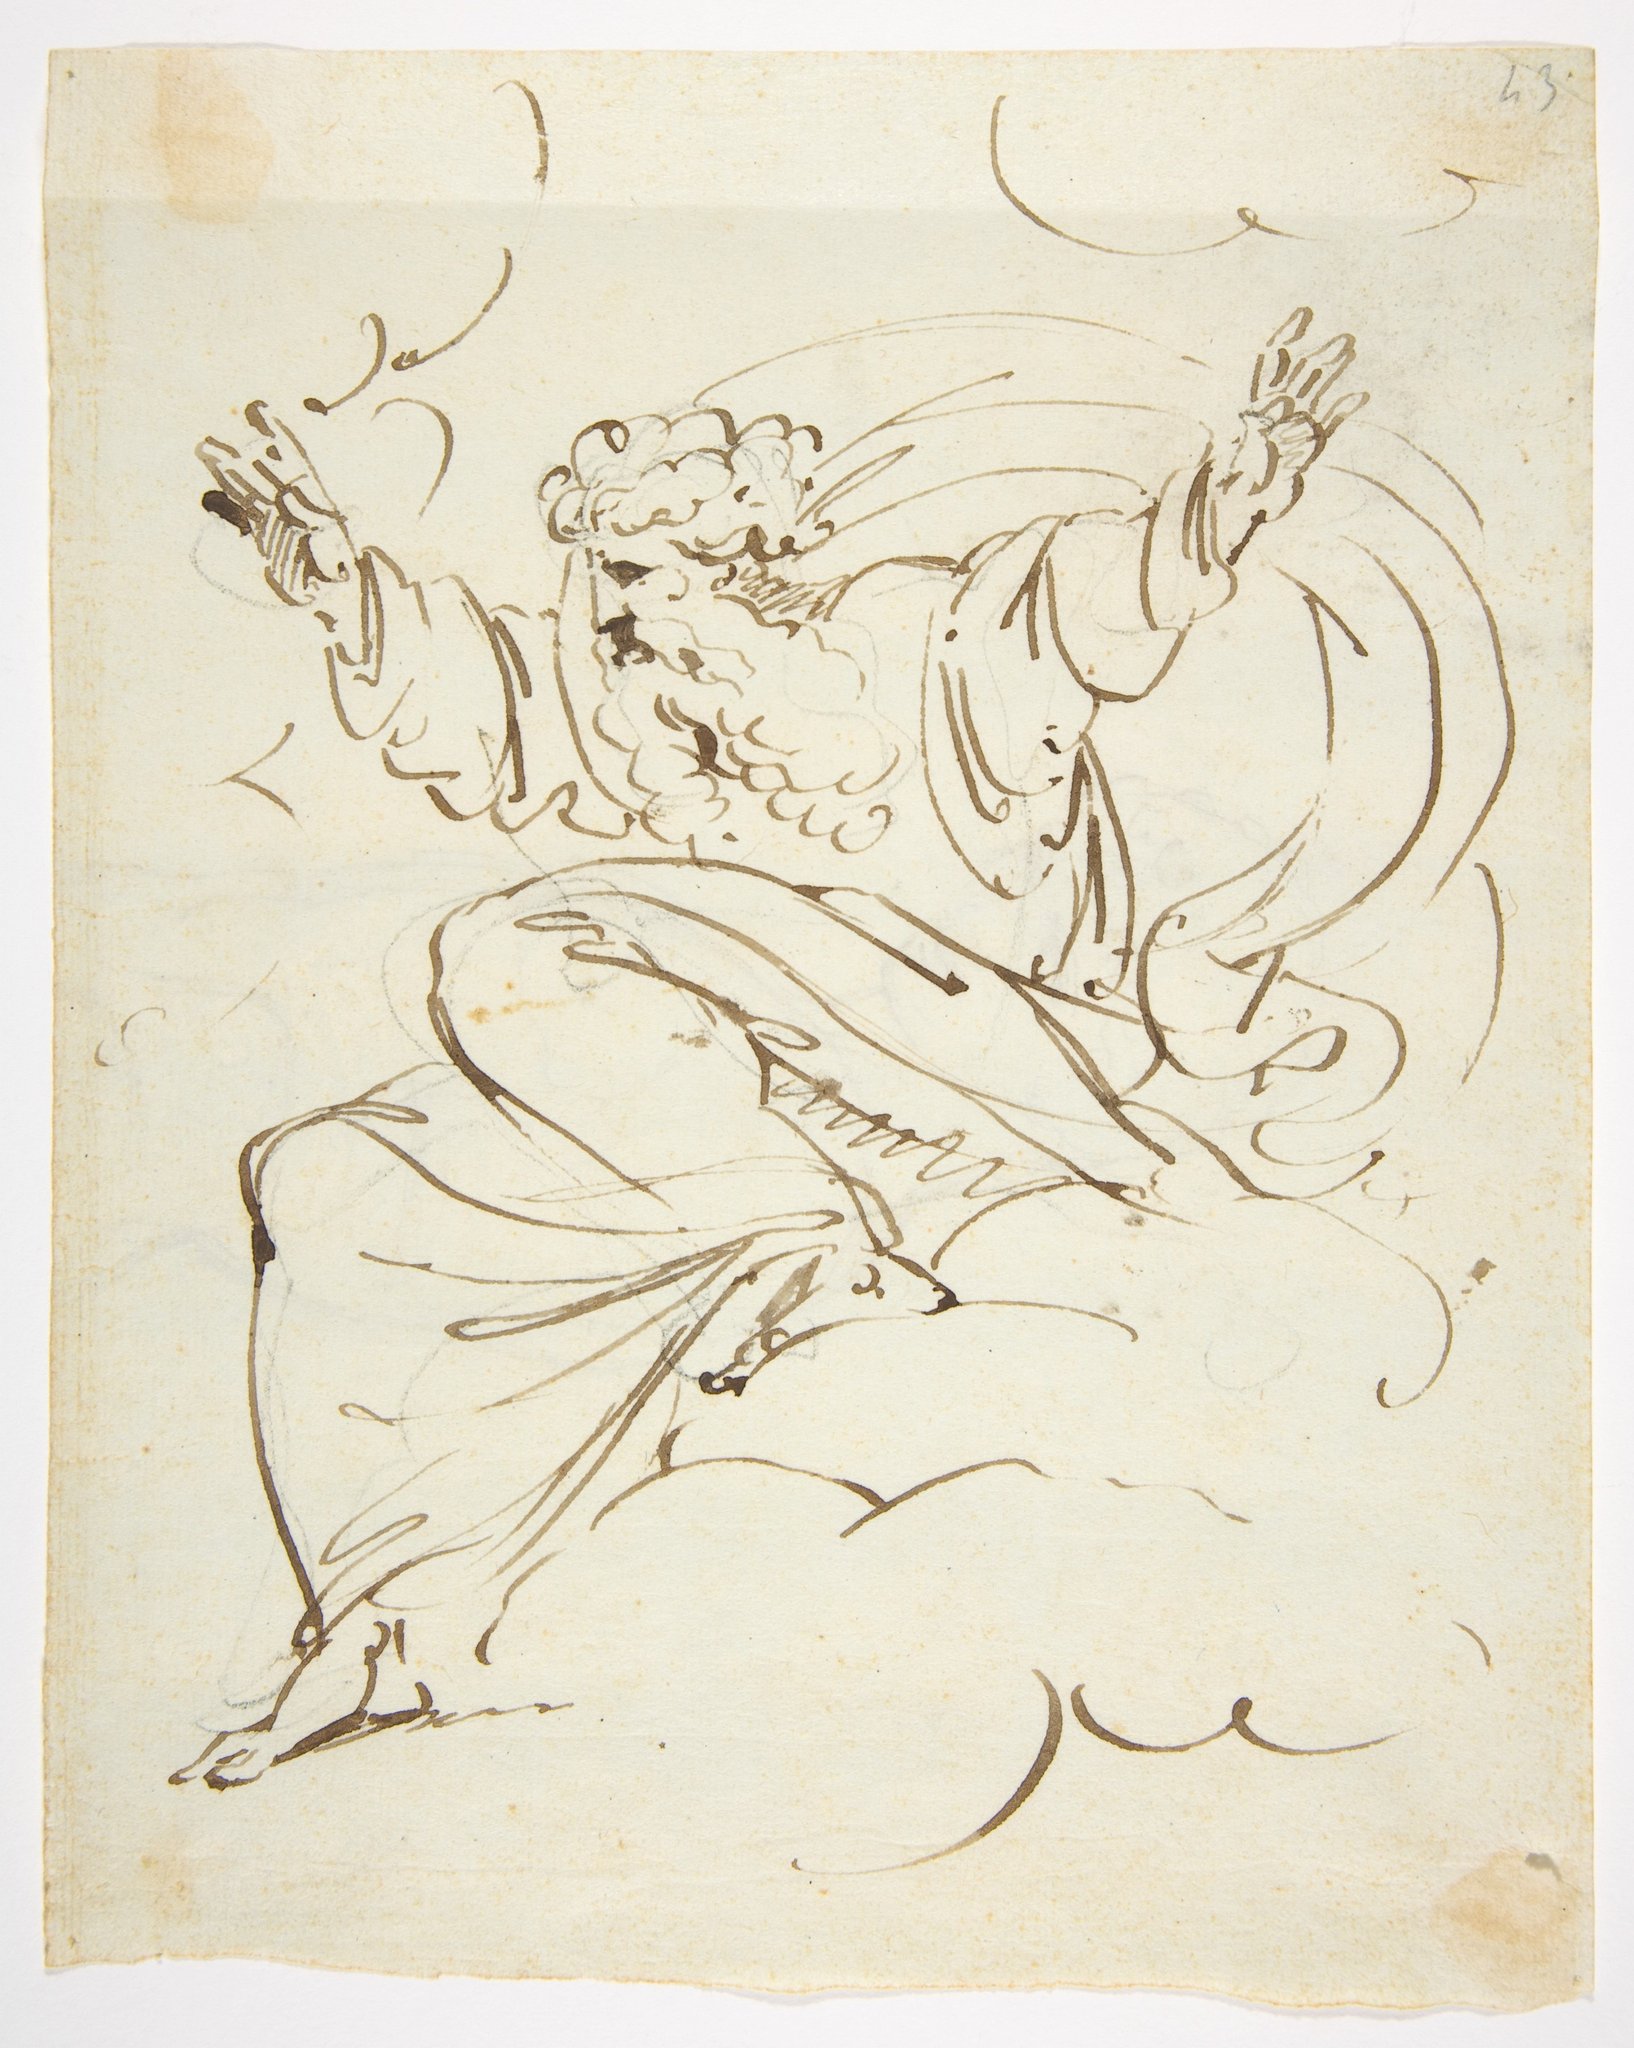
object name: drawing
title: God The Father Creating (?) (recto); Study of neo-classical statue of a nude male (verso)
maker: luigi sabatelli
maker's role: artist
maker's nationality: italian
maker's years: 1772-1850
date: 1772-1850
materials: graphite, ink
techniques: pen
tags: god the father